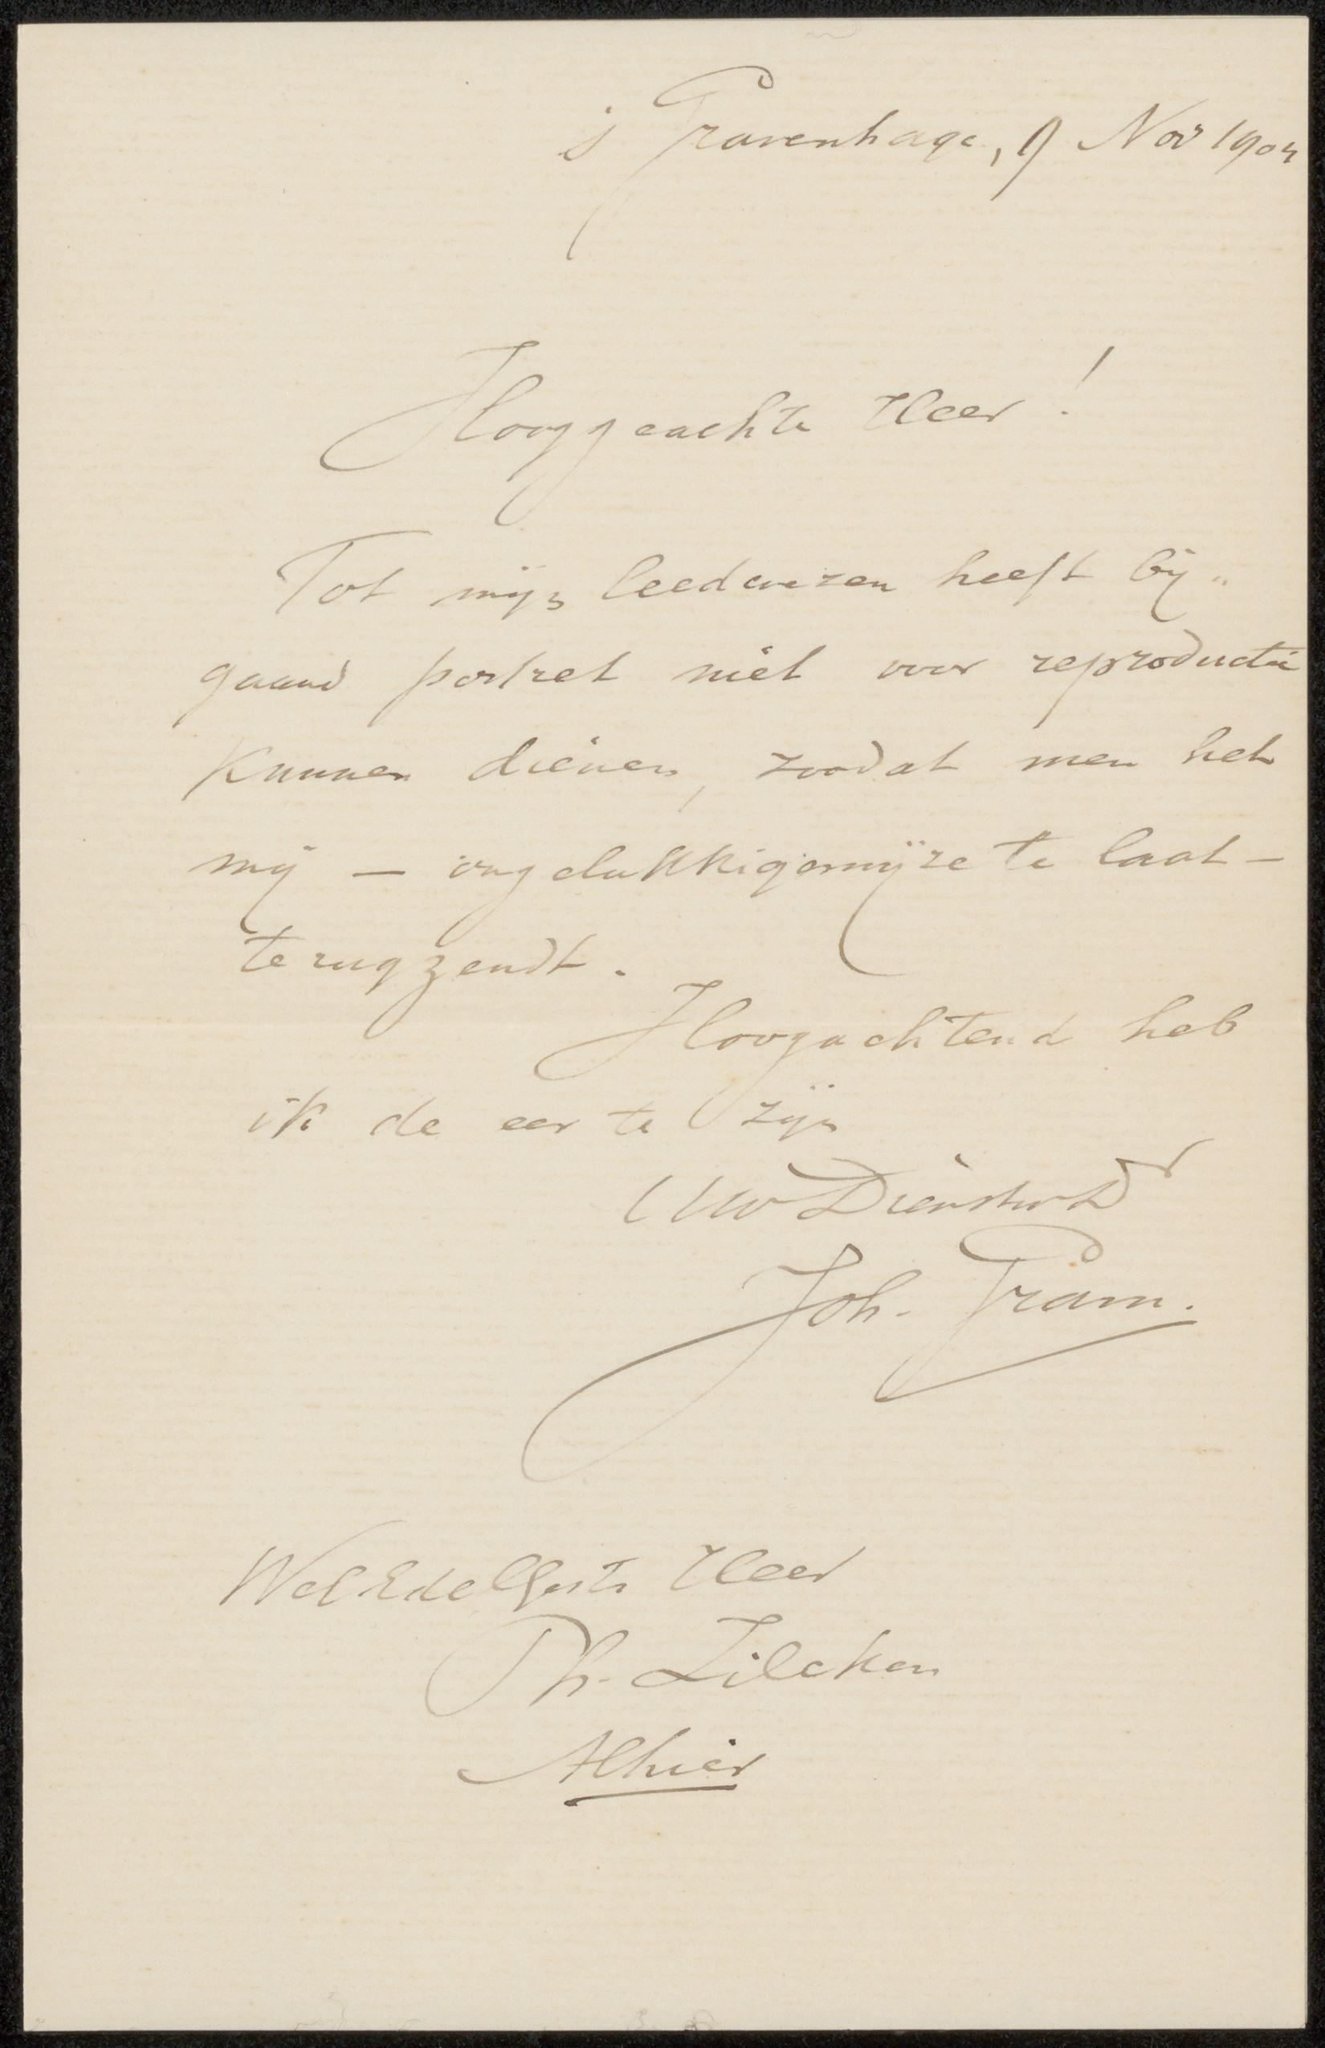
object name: letter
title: Brief aan Philip Zilcken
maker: johan gram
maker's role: kunstcriticus, letterkundige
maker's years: 1833-1914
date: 1904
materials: ink, paper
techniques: pen, writing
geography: the hague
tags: painter, philip zilcken, historical persons (portraits and scenes from the life)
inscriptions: collector's mark: ‘RPK’